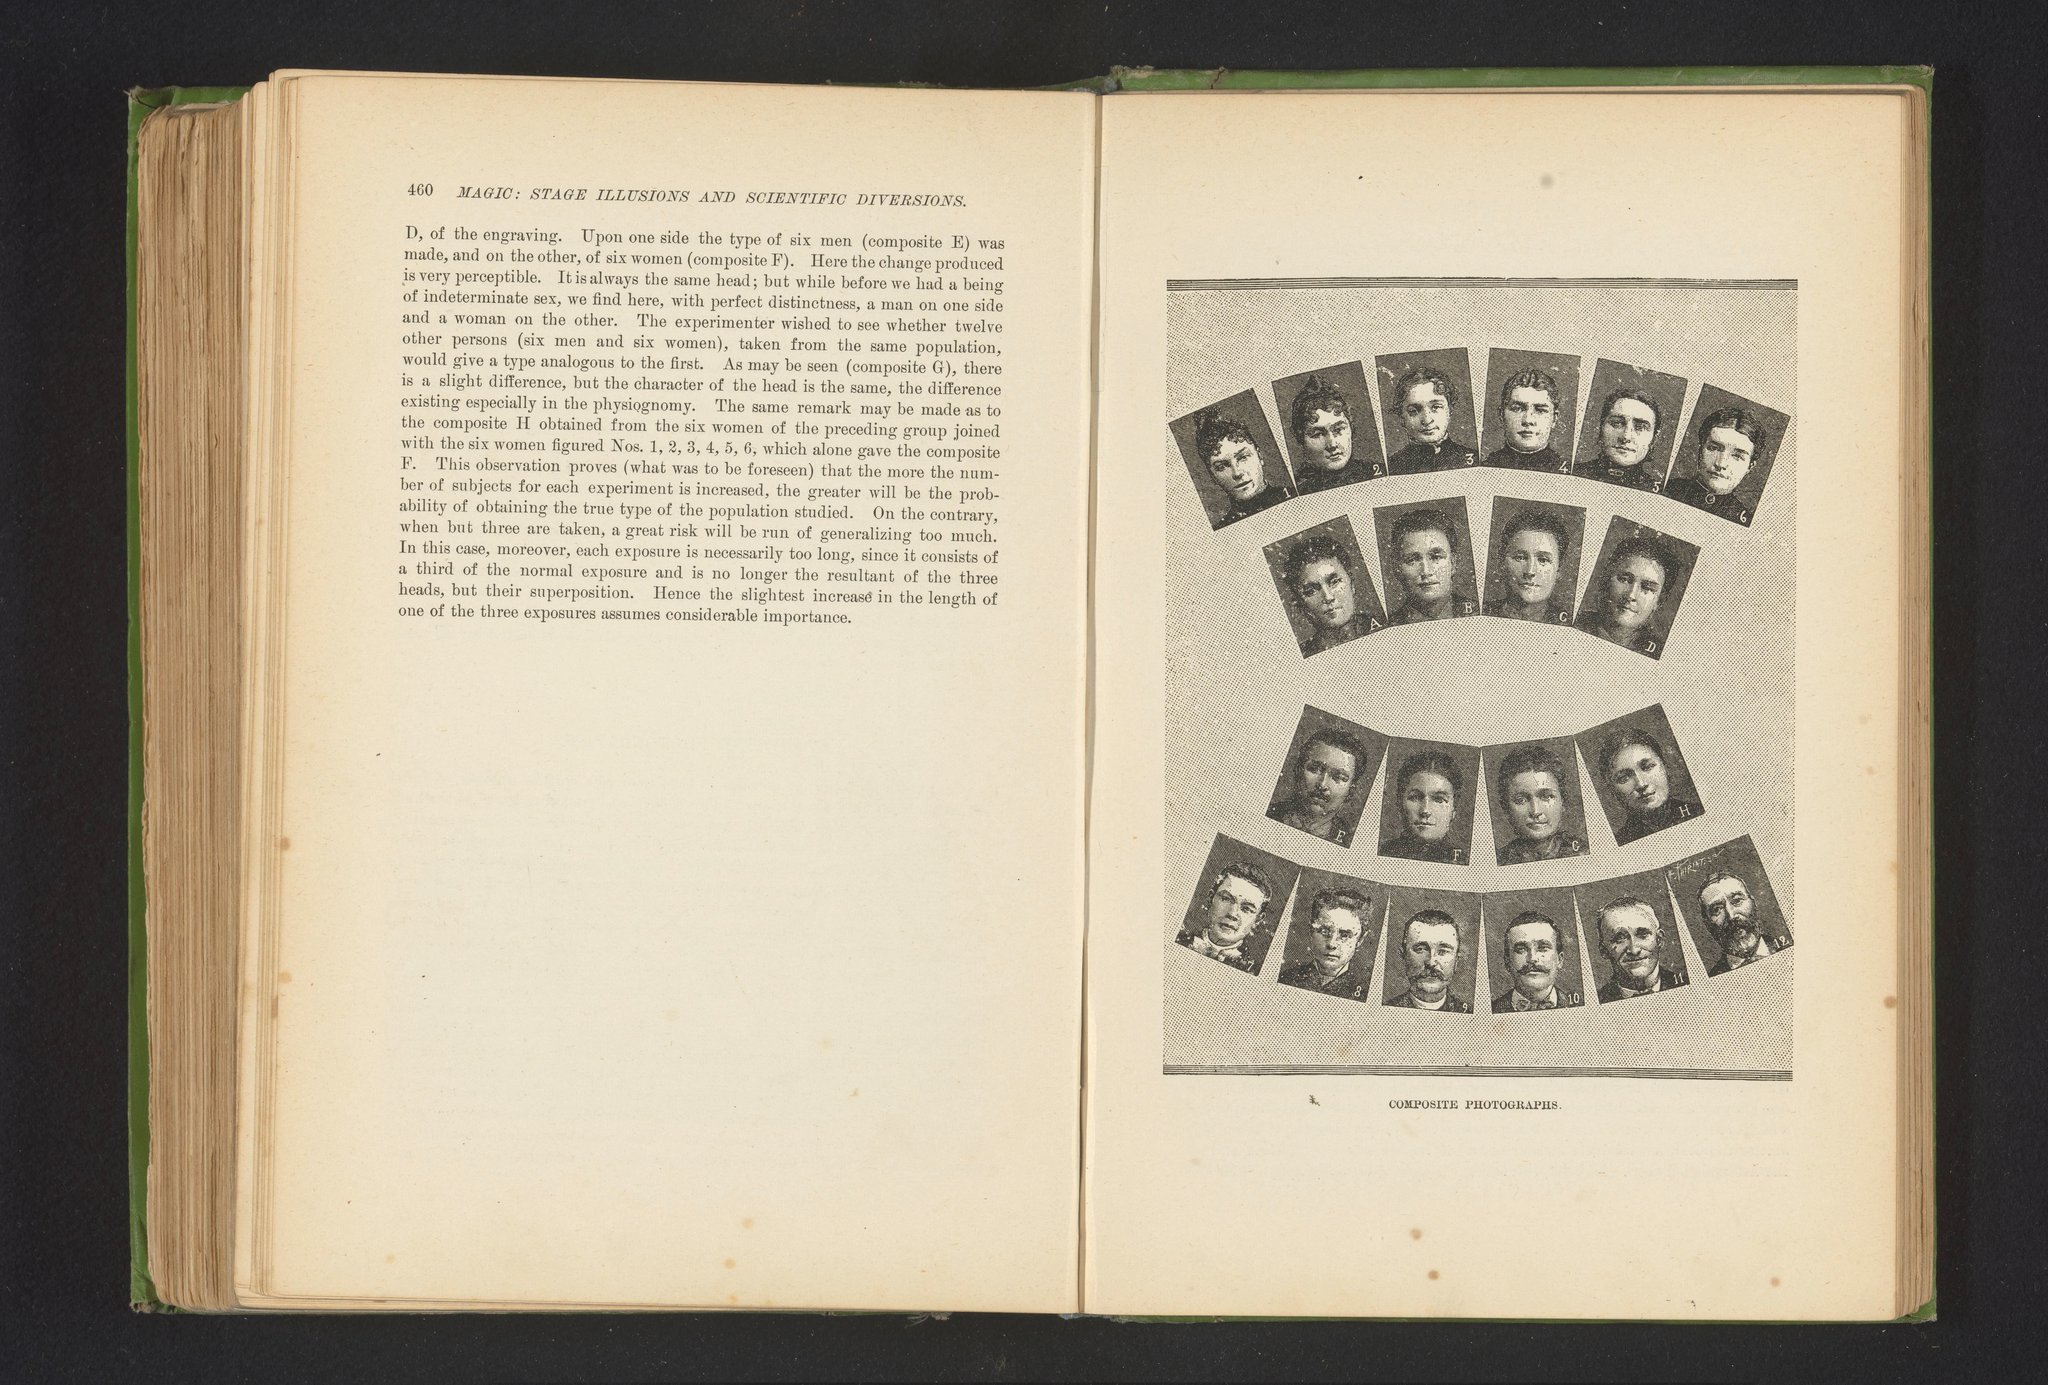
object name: photomechanical print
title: Composite Photographs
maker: Anonymous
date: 1892-1897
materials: paper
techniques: autotype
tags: historical persons not known by name - bb - woman, historical persons not known by name